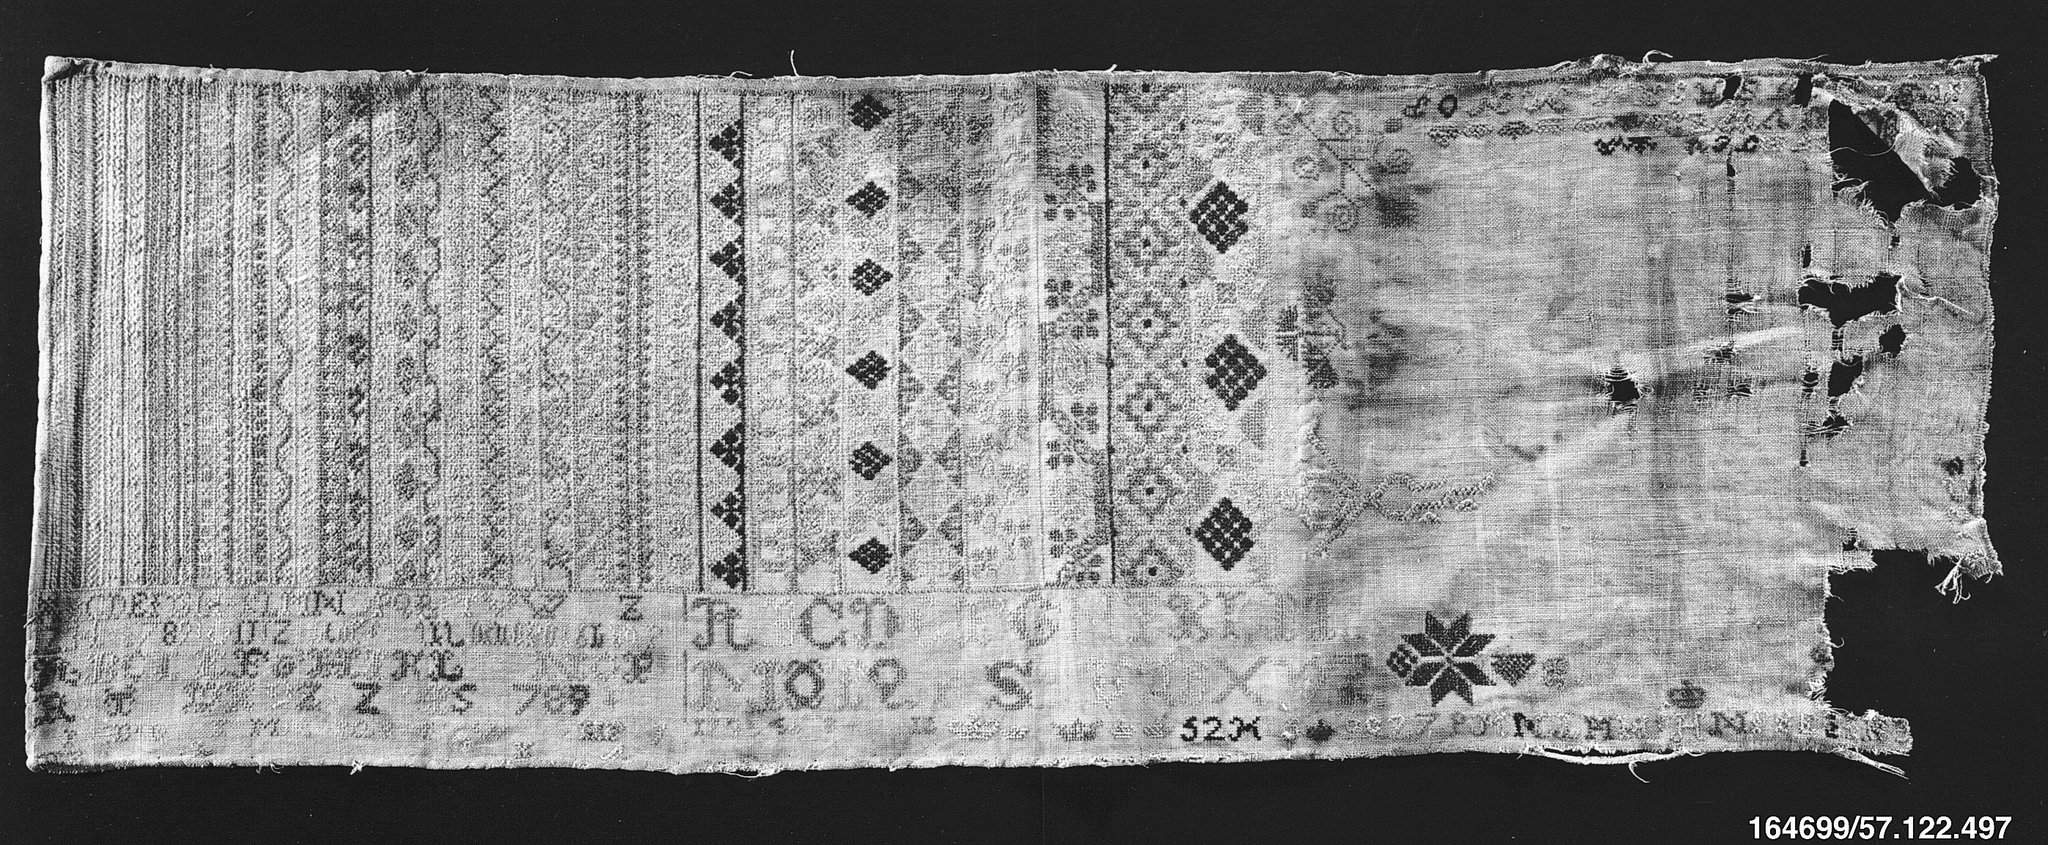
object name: sampler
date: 1801-1900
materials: linen, silk